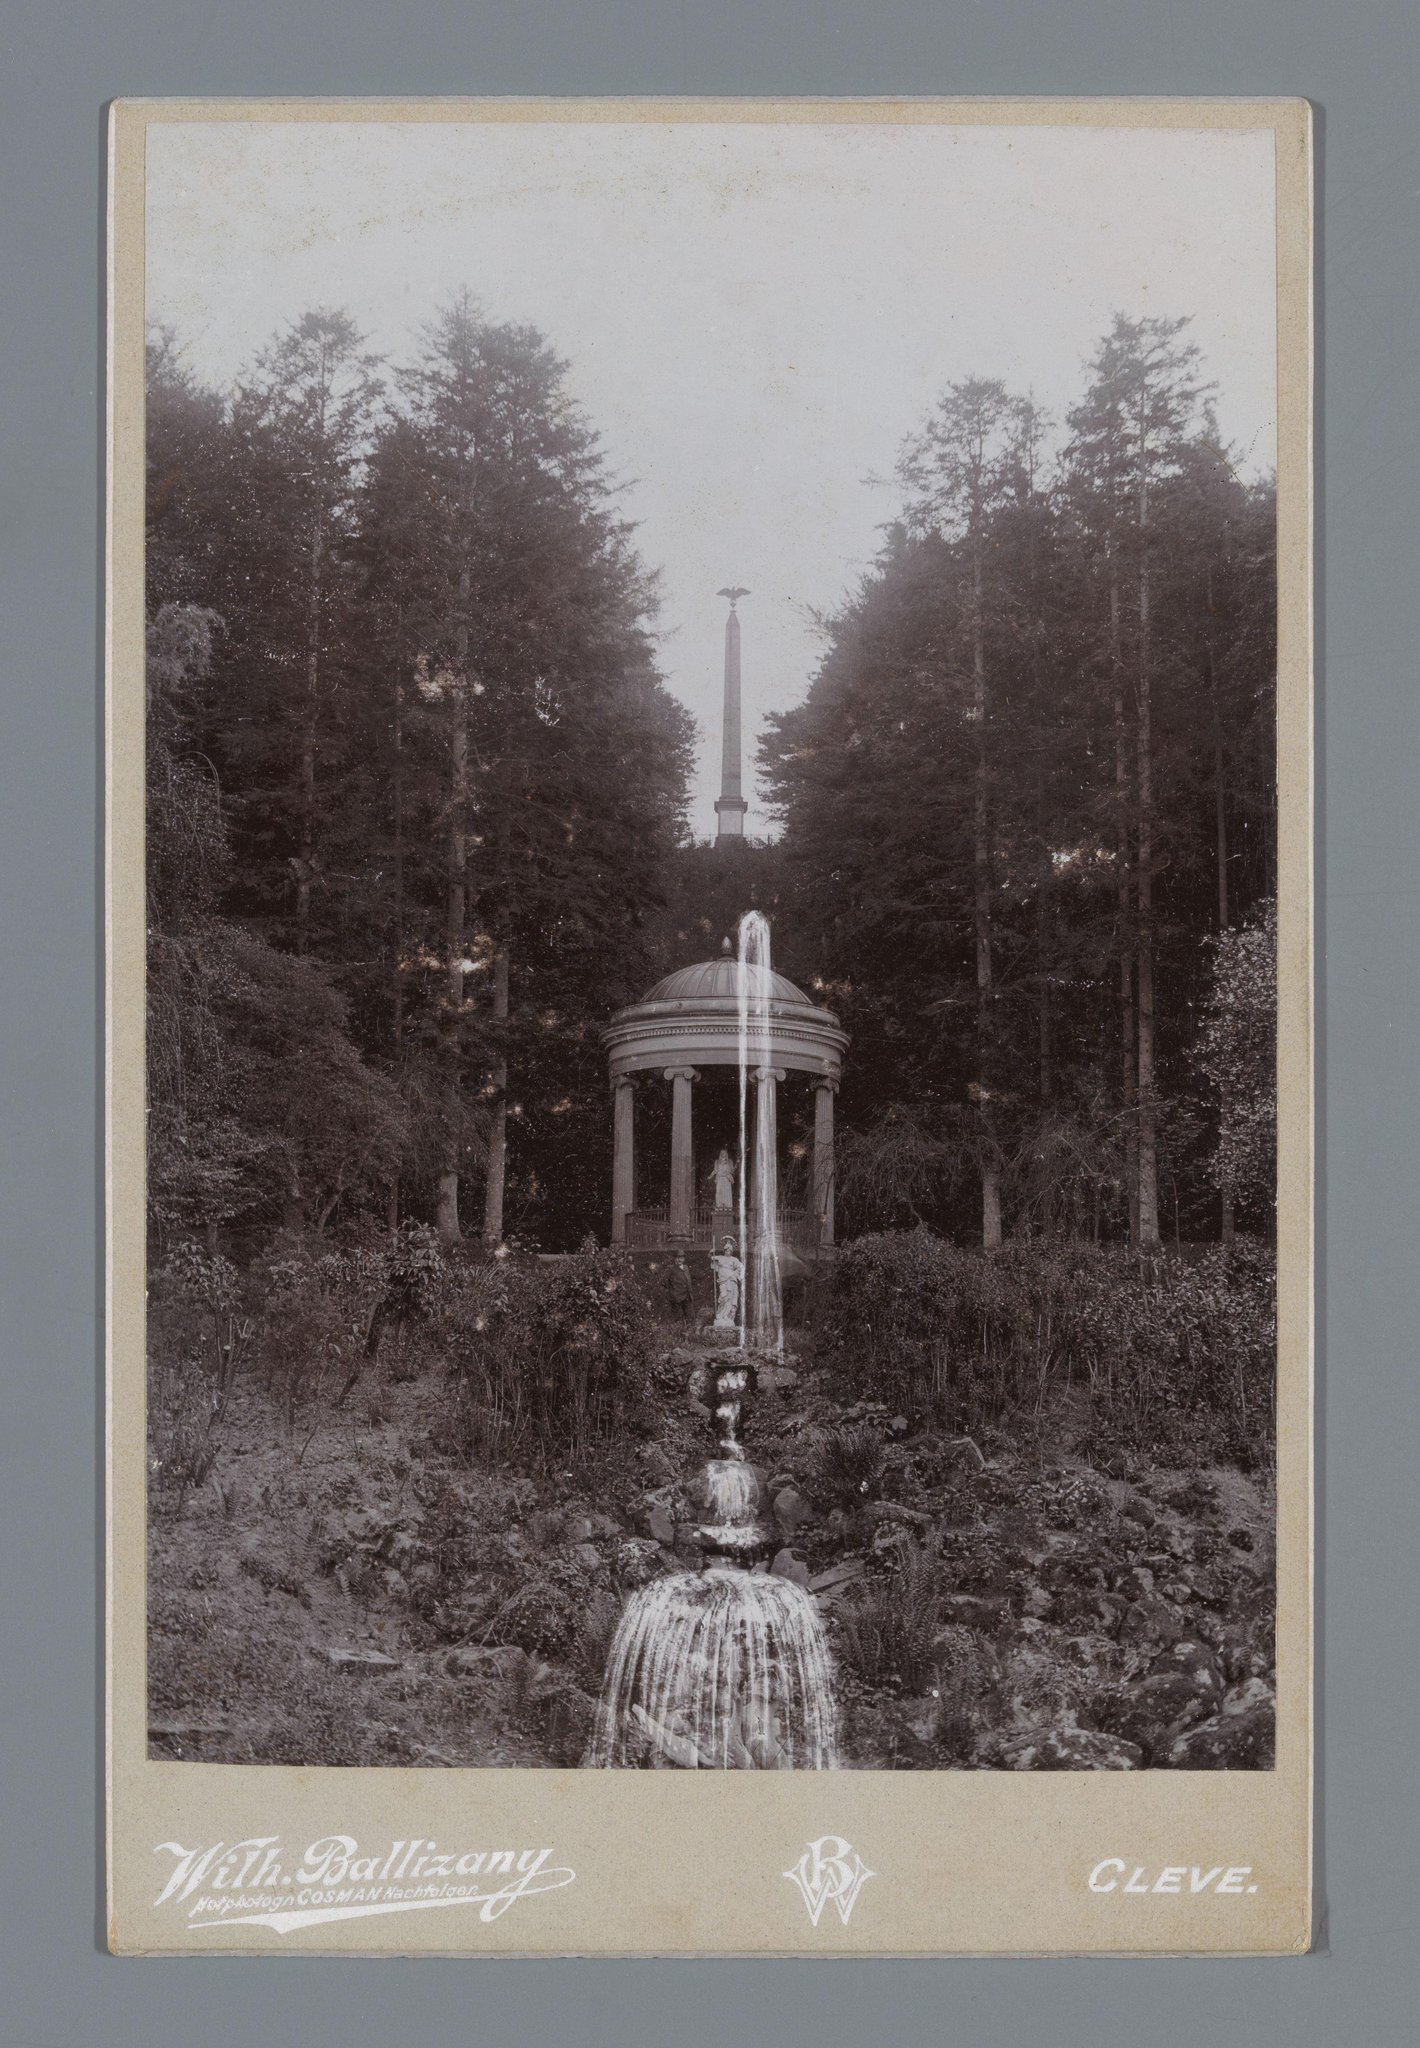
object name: cabinet photograph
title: Amfitheater en Springenberg in Kleef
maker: wilhelm ballizany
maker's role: fotograaf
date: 1880-1940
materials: cardboard, photographic support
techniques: collodion silver print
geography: cleves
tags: garden, ornamental fountain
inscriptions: inscription: ‘Bad Cleve’